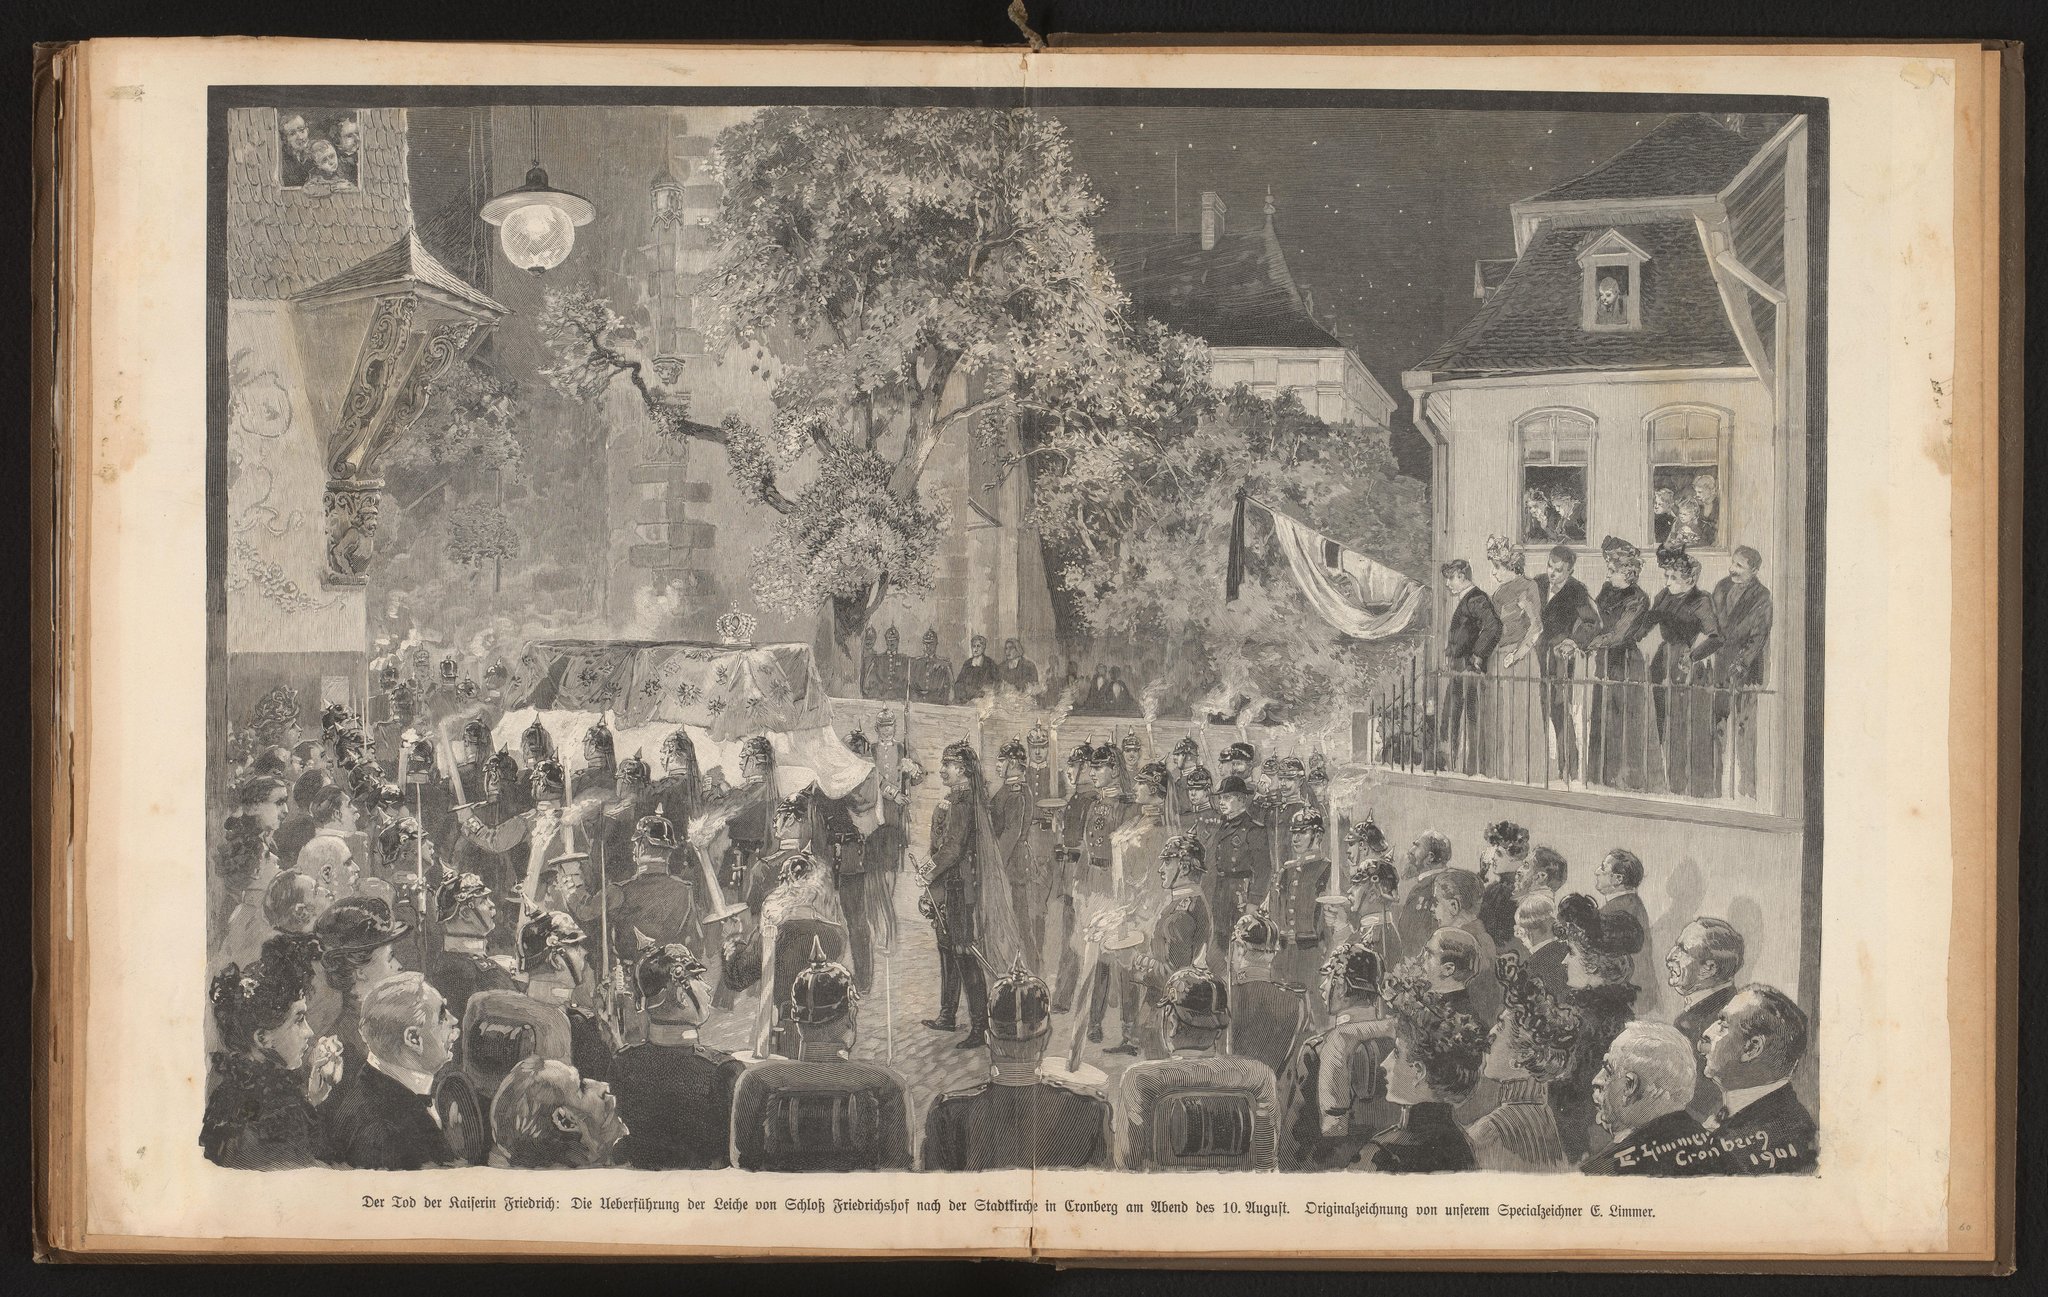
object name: album leaf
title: Rouwstoet voor keizerin Victoria in Kronberg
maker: emil limmer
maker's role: draughtsman, painter, print maker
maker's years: 1854-1931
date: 1901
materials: paper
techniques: engraving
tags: victoria van saksen-coburg en gotha (duits keizerin), public funeral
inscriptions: inscription: ‘Der Tod der Kaiserin Friedrich (...) Specialzeichner E. Limmer.’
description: Deze prent is verdeeld over twee pagina's.